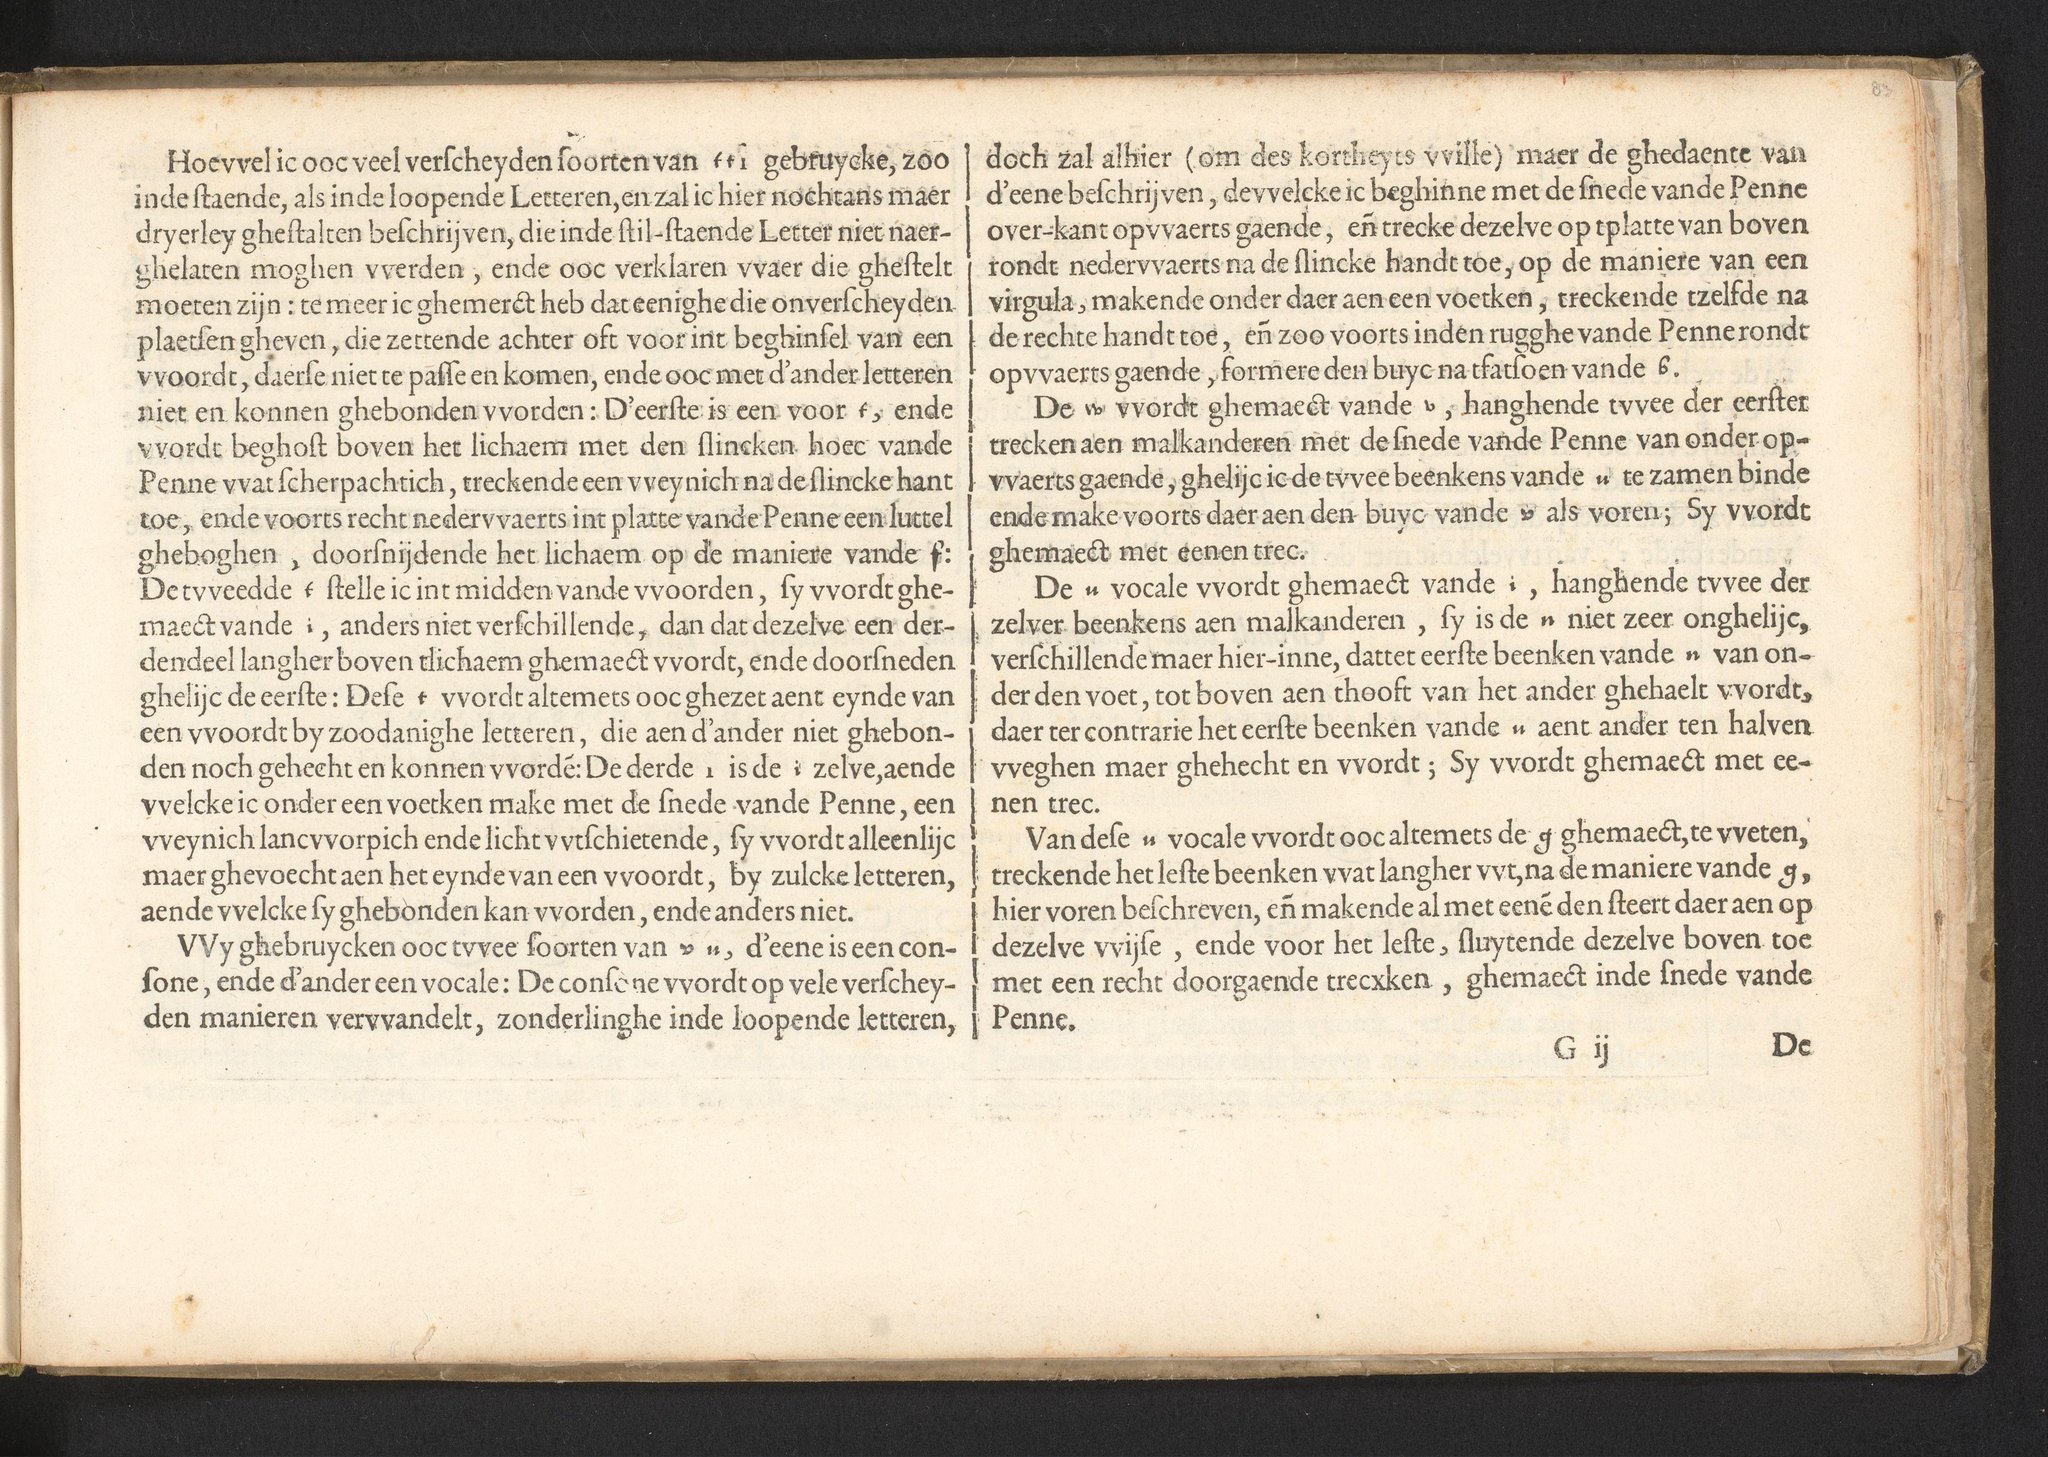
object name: album leaf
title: Instructie bij het schrijven van de Nederlandse letteren (vierde vervolg)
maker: jan van de velde (i)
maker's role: painter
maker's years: 1568-1623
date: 1605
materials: paper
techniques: letterpress printing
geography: rotterdam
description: Folio G2r met het vierde vervolg van de instructie bij het schrijven van de Nederlandse letteren. Het blad maakt deel uit van een album.